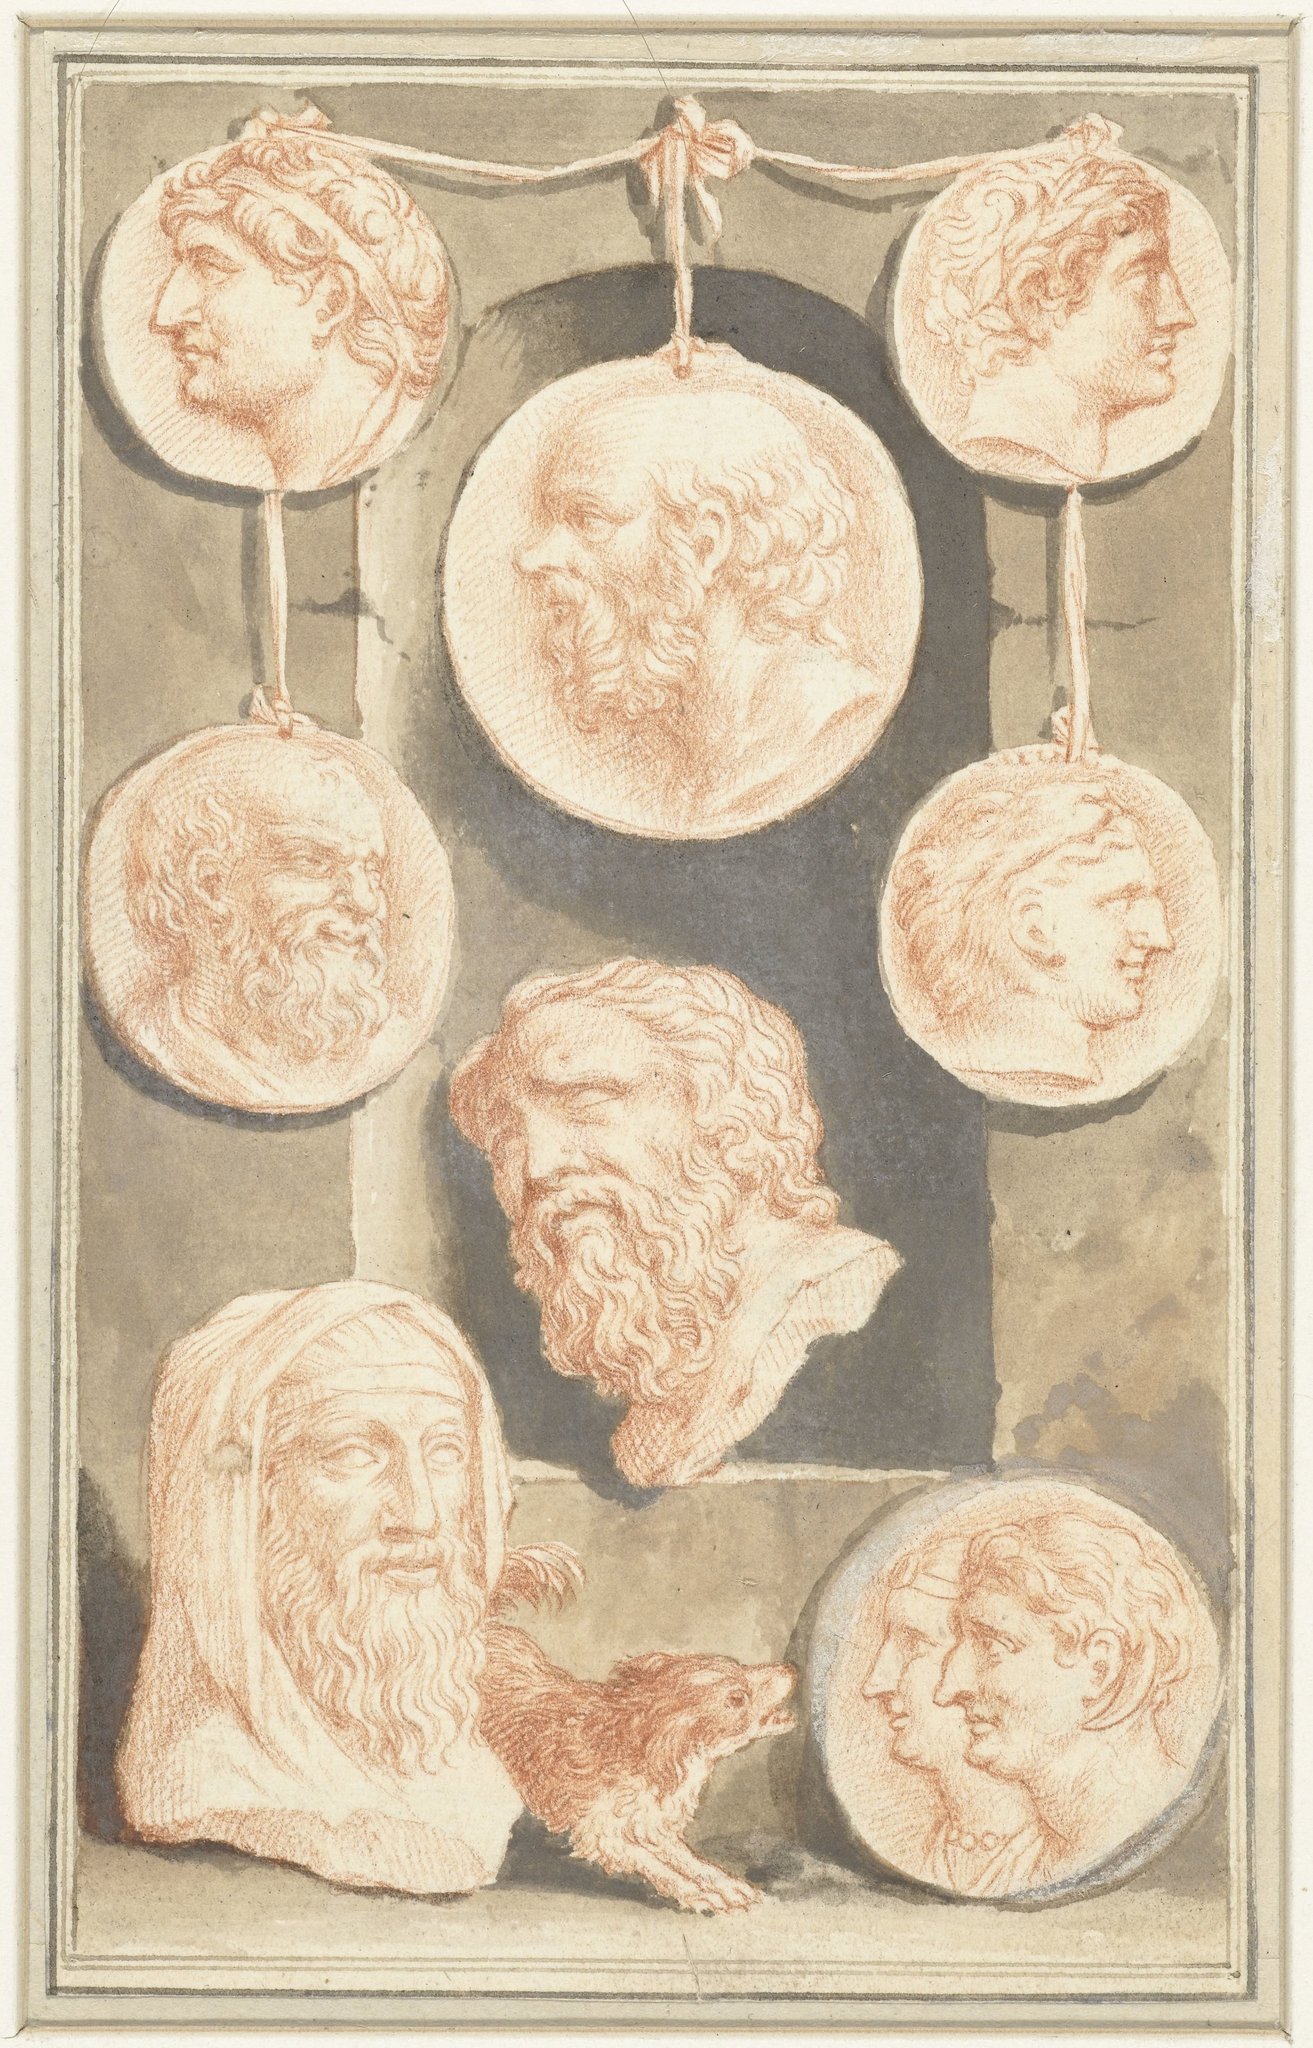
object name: design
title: Compositie van portretmedaillons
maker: jacob houbraken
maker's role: draughtsman, print maker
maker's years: 1698-1780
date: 1708-1780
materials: chalk, ink, paper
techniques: brush, pen